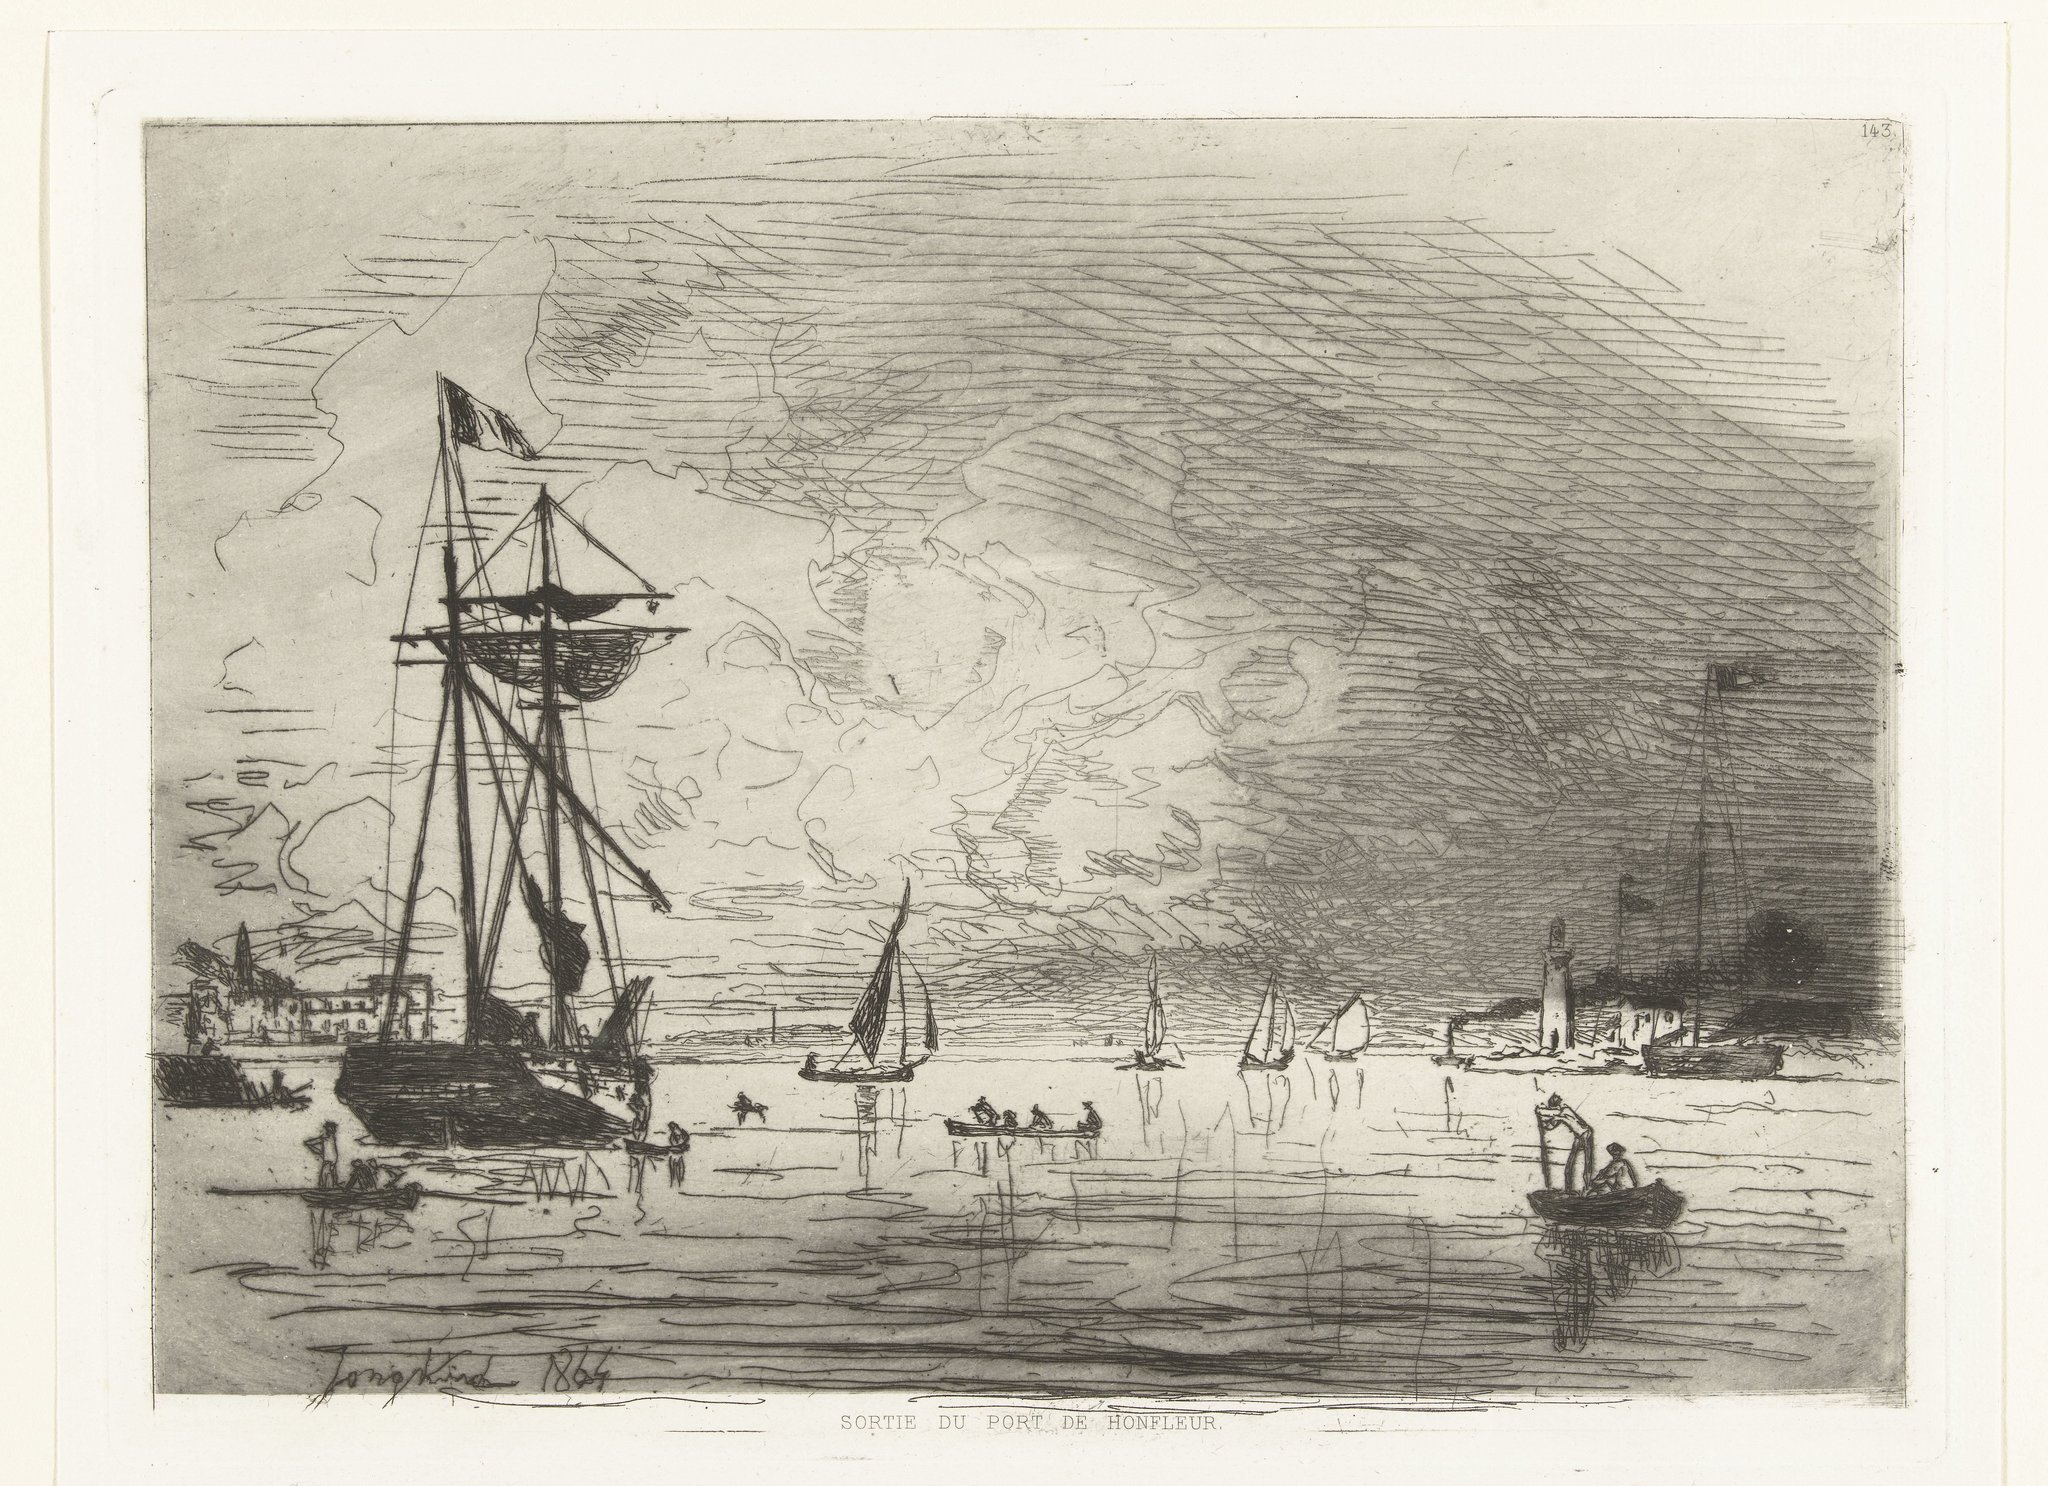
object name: print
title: Uitgang van de haven van Honfleur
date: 1864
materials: paper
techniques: etching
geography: london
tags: harbour, ships (in general)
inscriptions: collector's mark: Lugt 2228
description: Gezicht op de uitgang van de haven van Honfleur. Op de voorgrond een groot zeilschip met gestreken zeilen, daarnaast enkele sloepen. Rechts op de achtergrond een vuurtoren, links een aantal huizen.